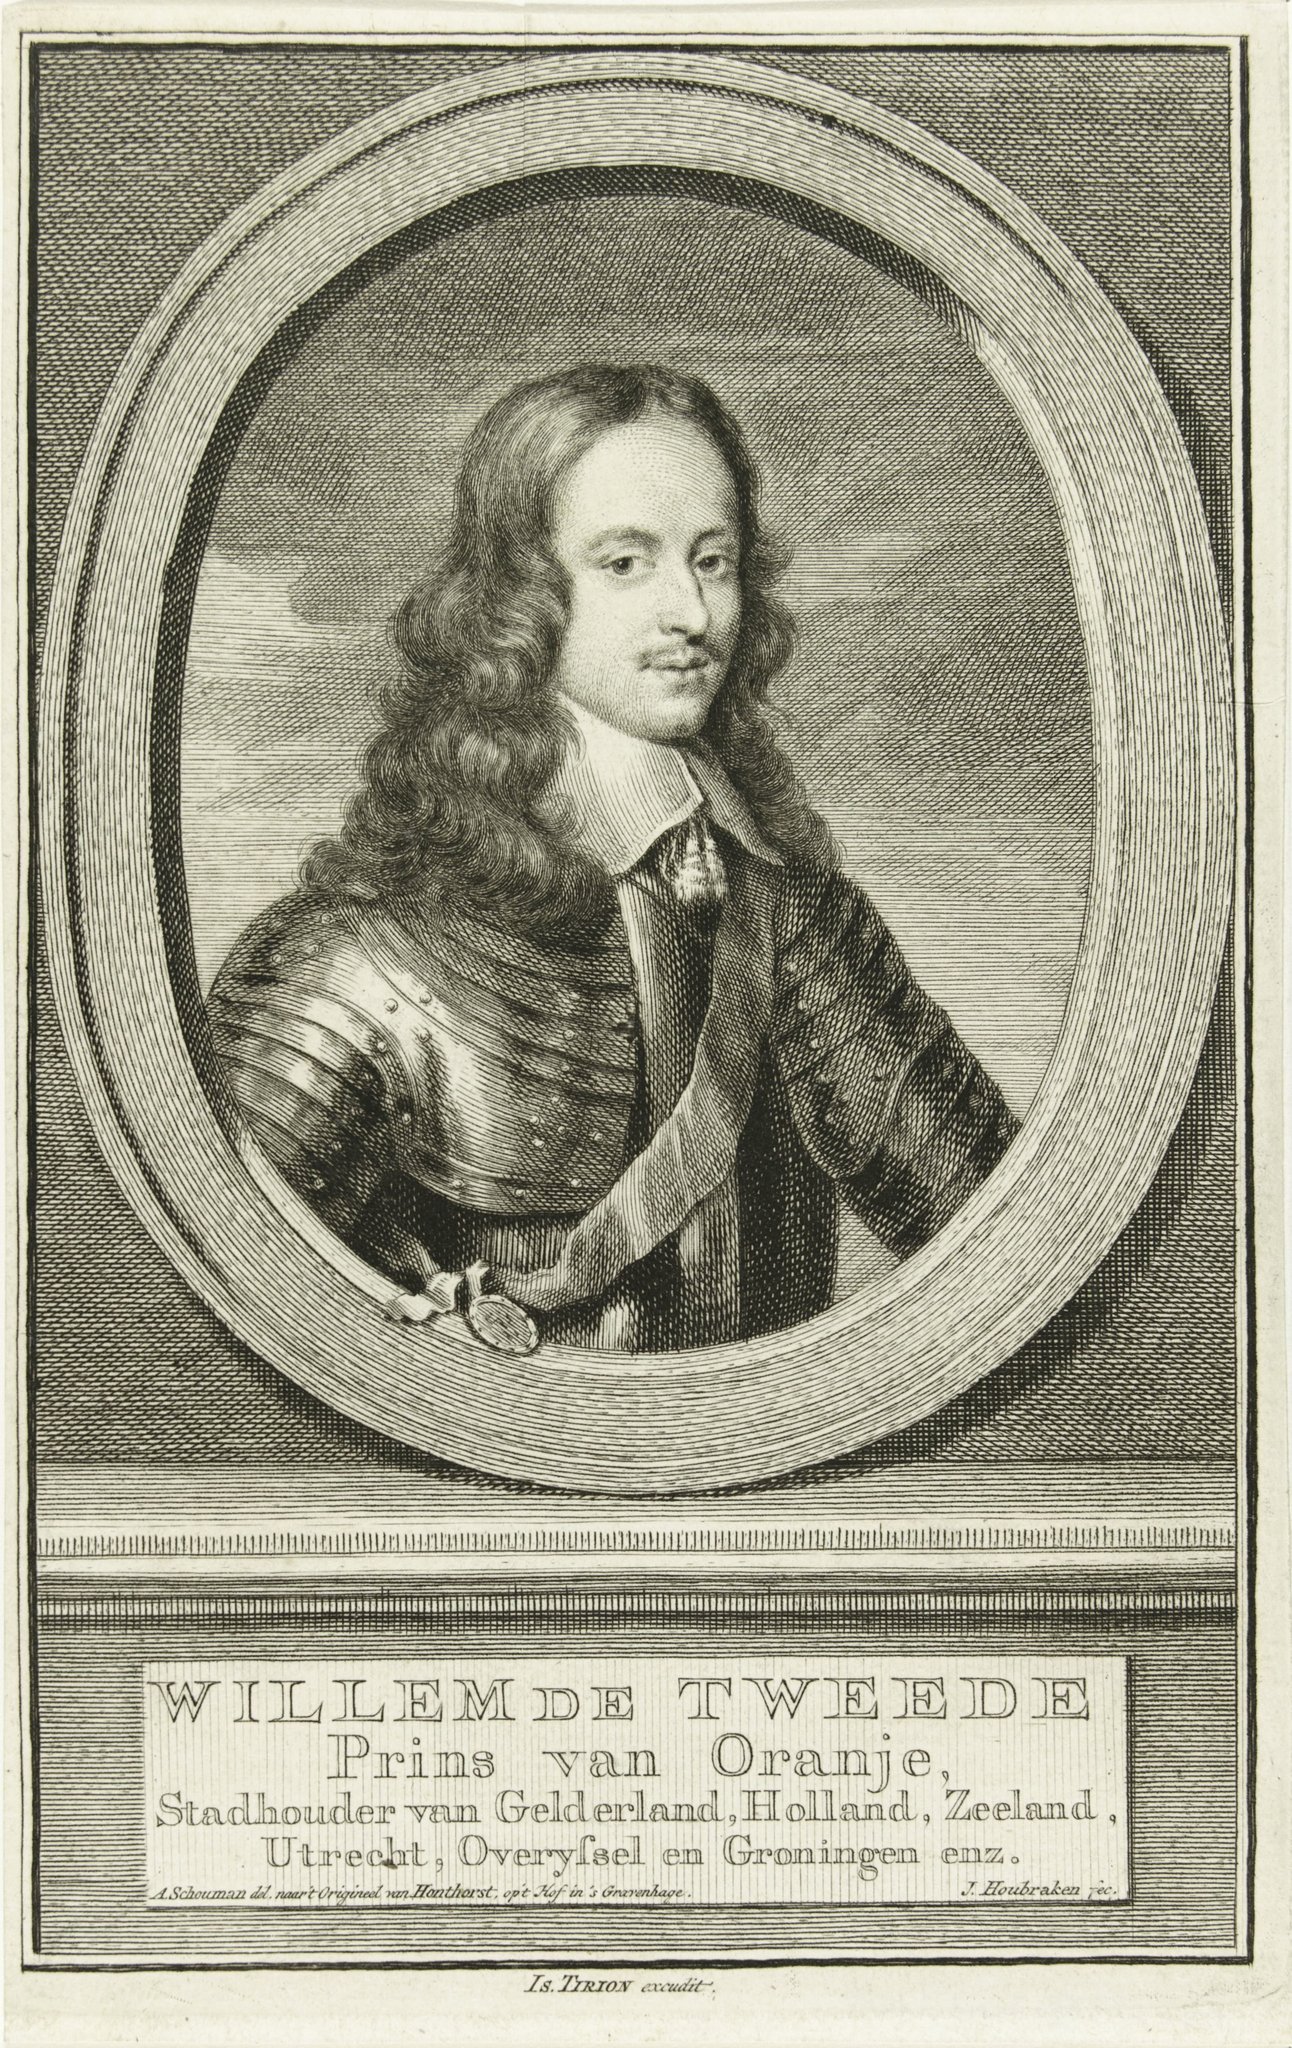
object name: print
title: Portret van Willem II, prins van Oranje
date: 1749-1759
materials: paper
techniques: engraving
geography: amsterdam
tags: william ii (prince of orange), knighthood order (garter) - insignia of a knighthood order, e.g.: badge, chain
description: De hier vermelde titel verwijst naar de hoogst verkregen titel van de geportretteerde, niet per se naar de titel die de geportretteerde op deze voorstelling draagt. Prent uit: Wagenaar, Jan. Vaderlandsche historie. Amsterdam: Isaak Tirion, 1749-1759.